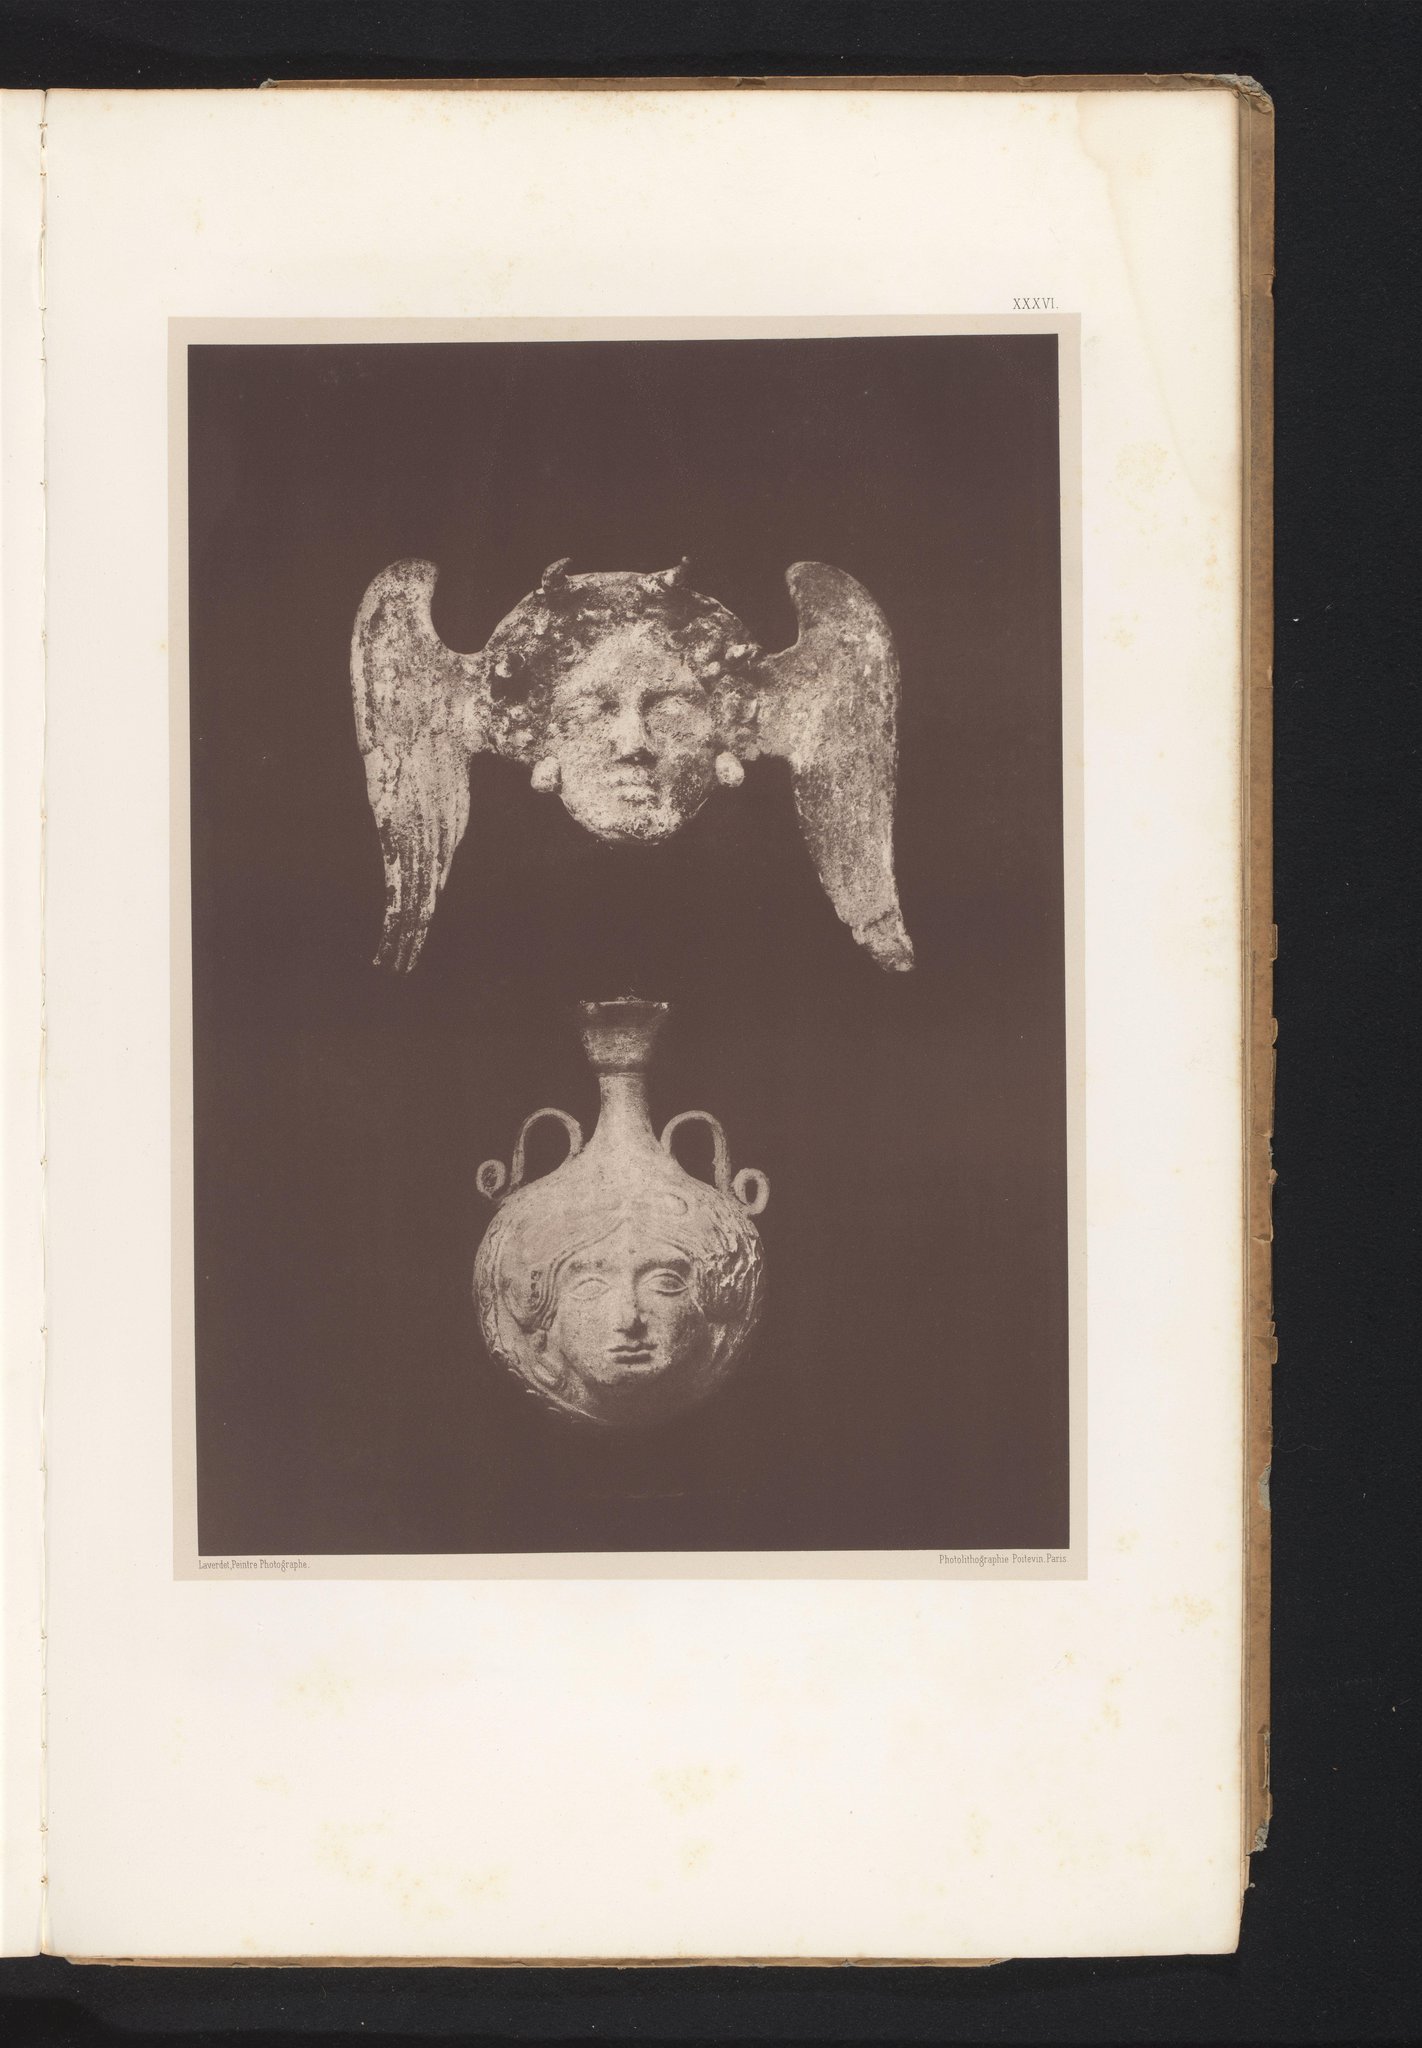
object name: photomechanical print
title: Terracotta sculptuur van het hoofd van Medusa met vleugels en een terracotta vaas met het gezicht van Medusa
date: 1852-1857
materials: paper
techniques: photolithography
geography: paris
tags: piece of sculpture, reproduction of a piece of sculpture (+ clay, sand, etc. ~ arts), medusa (one of the gorgons), container of stone: stone vase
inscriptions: number: ‘XXXVI.’